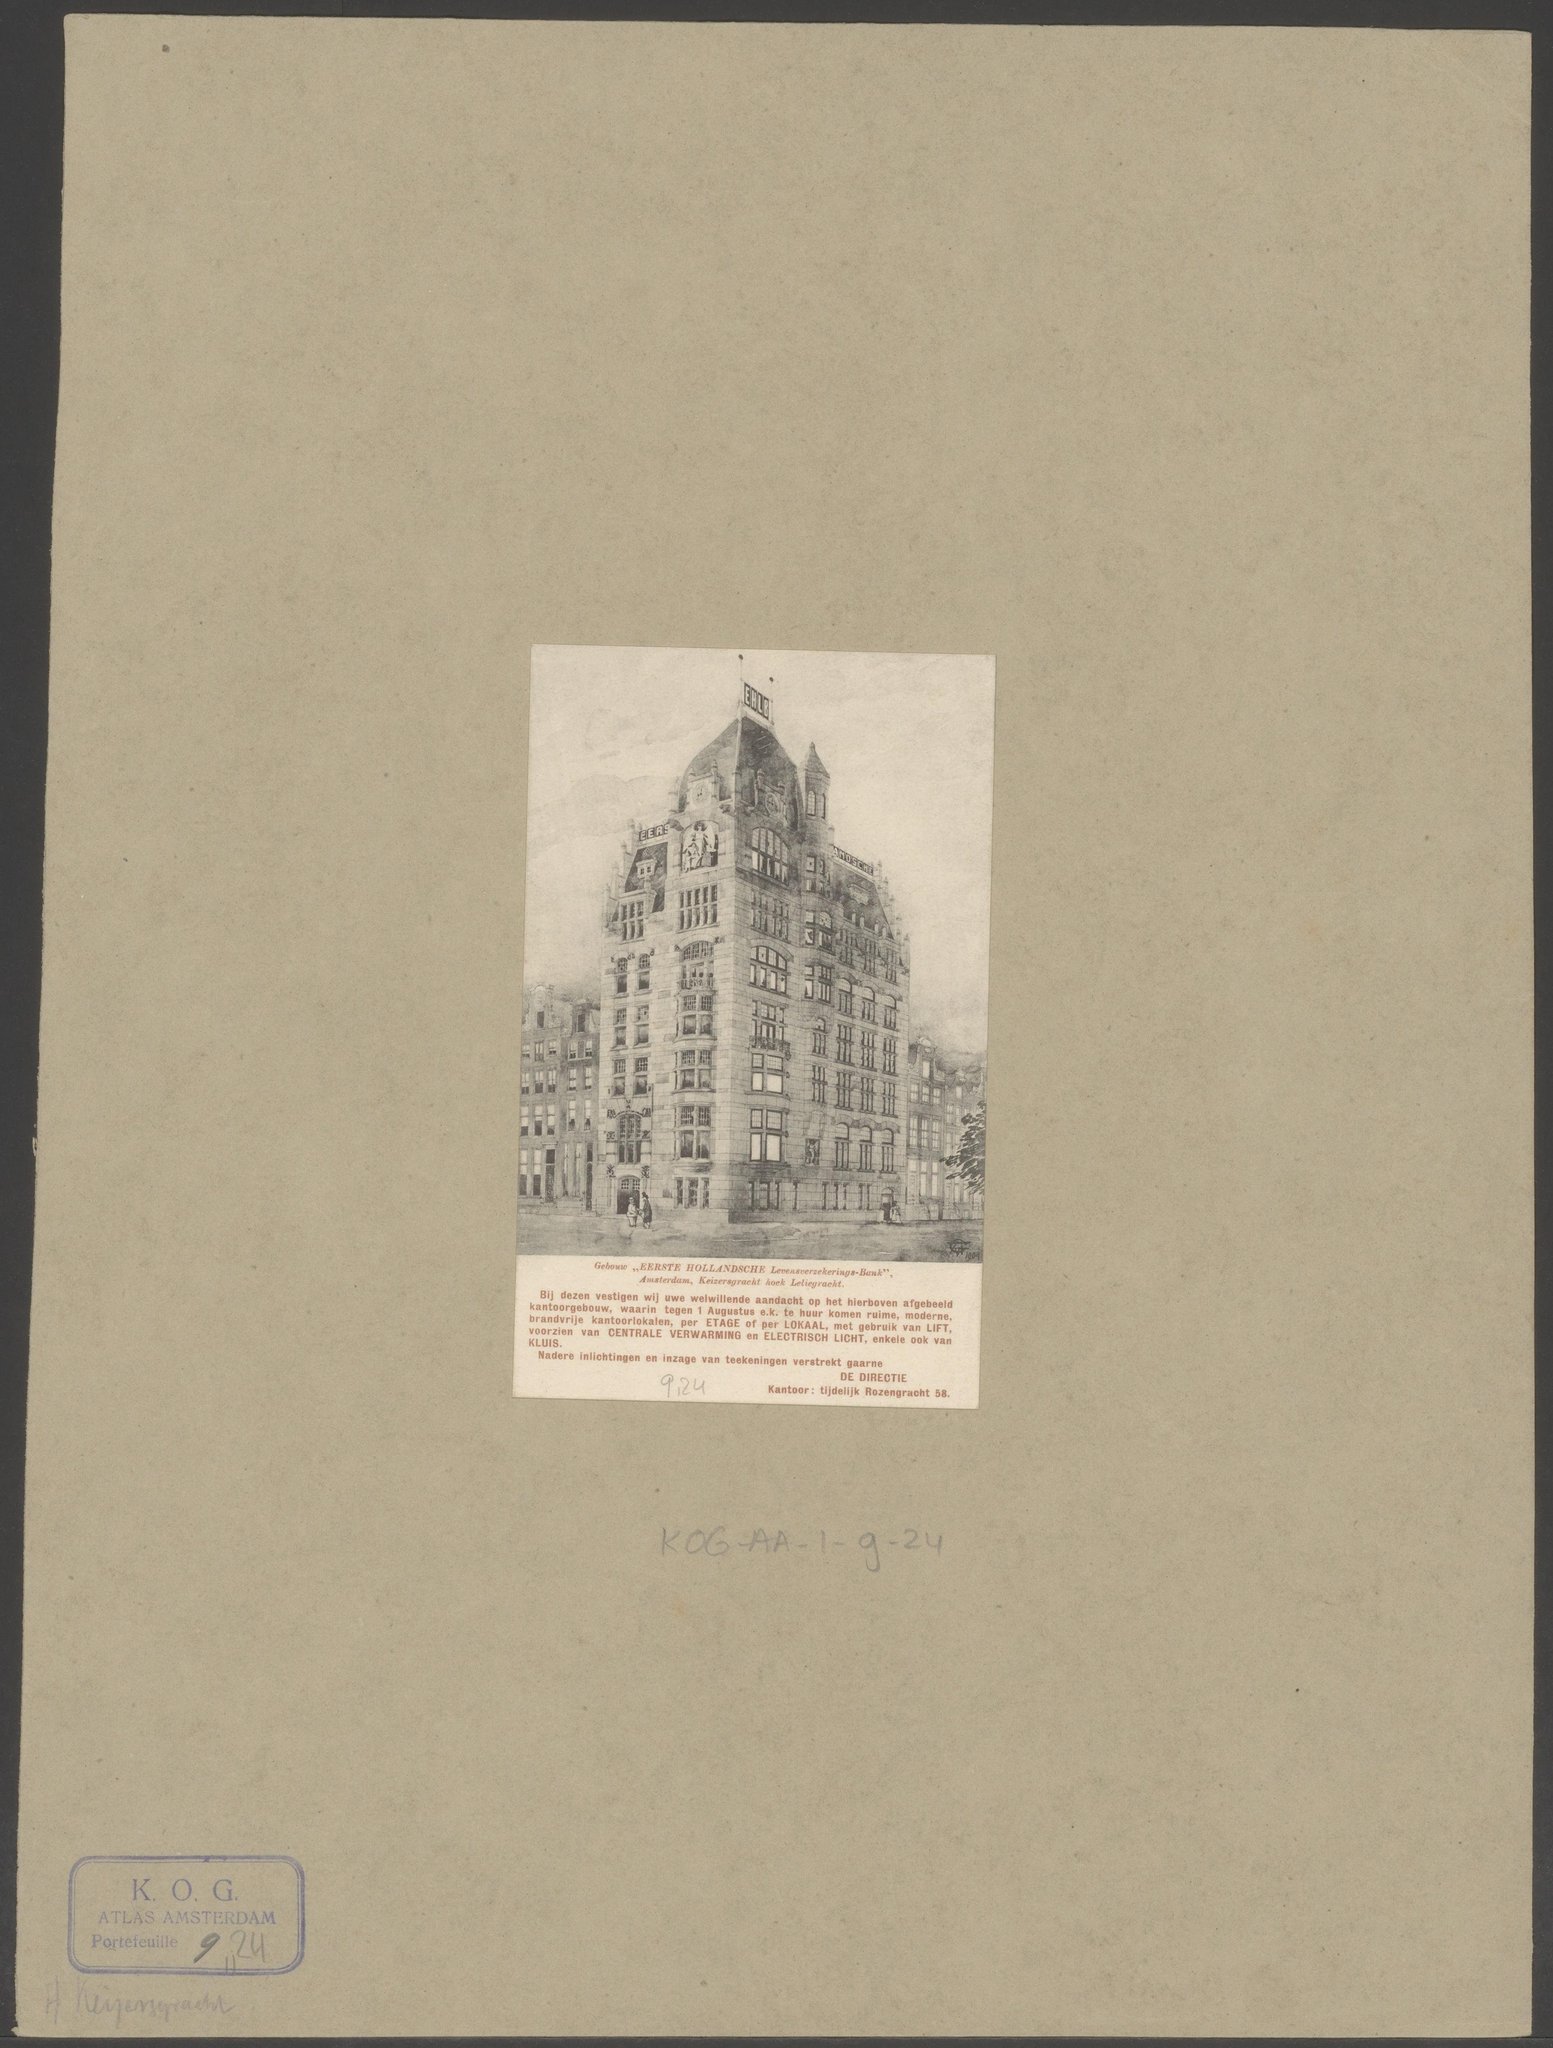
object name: advertising card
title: Gezicht op de Eerste Hollandsche Levensverzekerings-Bank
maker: Anonymous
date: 1888-1930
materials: cardboard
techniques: photograph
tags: city-view in general; 'veduta', façade (of house or building), street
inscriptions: collector's mark: ‘9,24’ Lugt 1641b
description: Onderwerpsrubriek binnen de Atlas Amsterdam: Kadijksplein, Karthuizerkerkhof, Kattegat, Kattenburg, Kapelsteeg O.Z., Enge Kerksteeg, Kerkstraat, Kinkerstraat, Kolk O.Z., Koningsplein, Kromboomsloot [Krom Boomssloot], Kostverlorenkade, Kwakersdwarspad, Kalverstraat, Keizersgracht (v.d. Brouwersgracht – Amstel), Klerensloot (Gedempte), Klimopstraat, Kloveniersburgwal, Kraansluis.